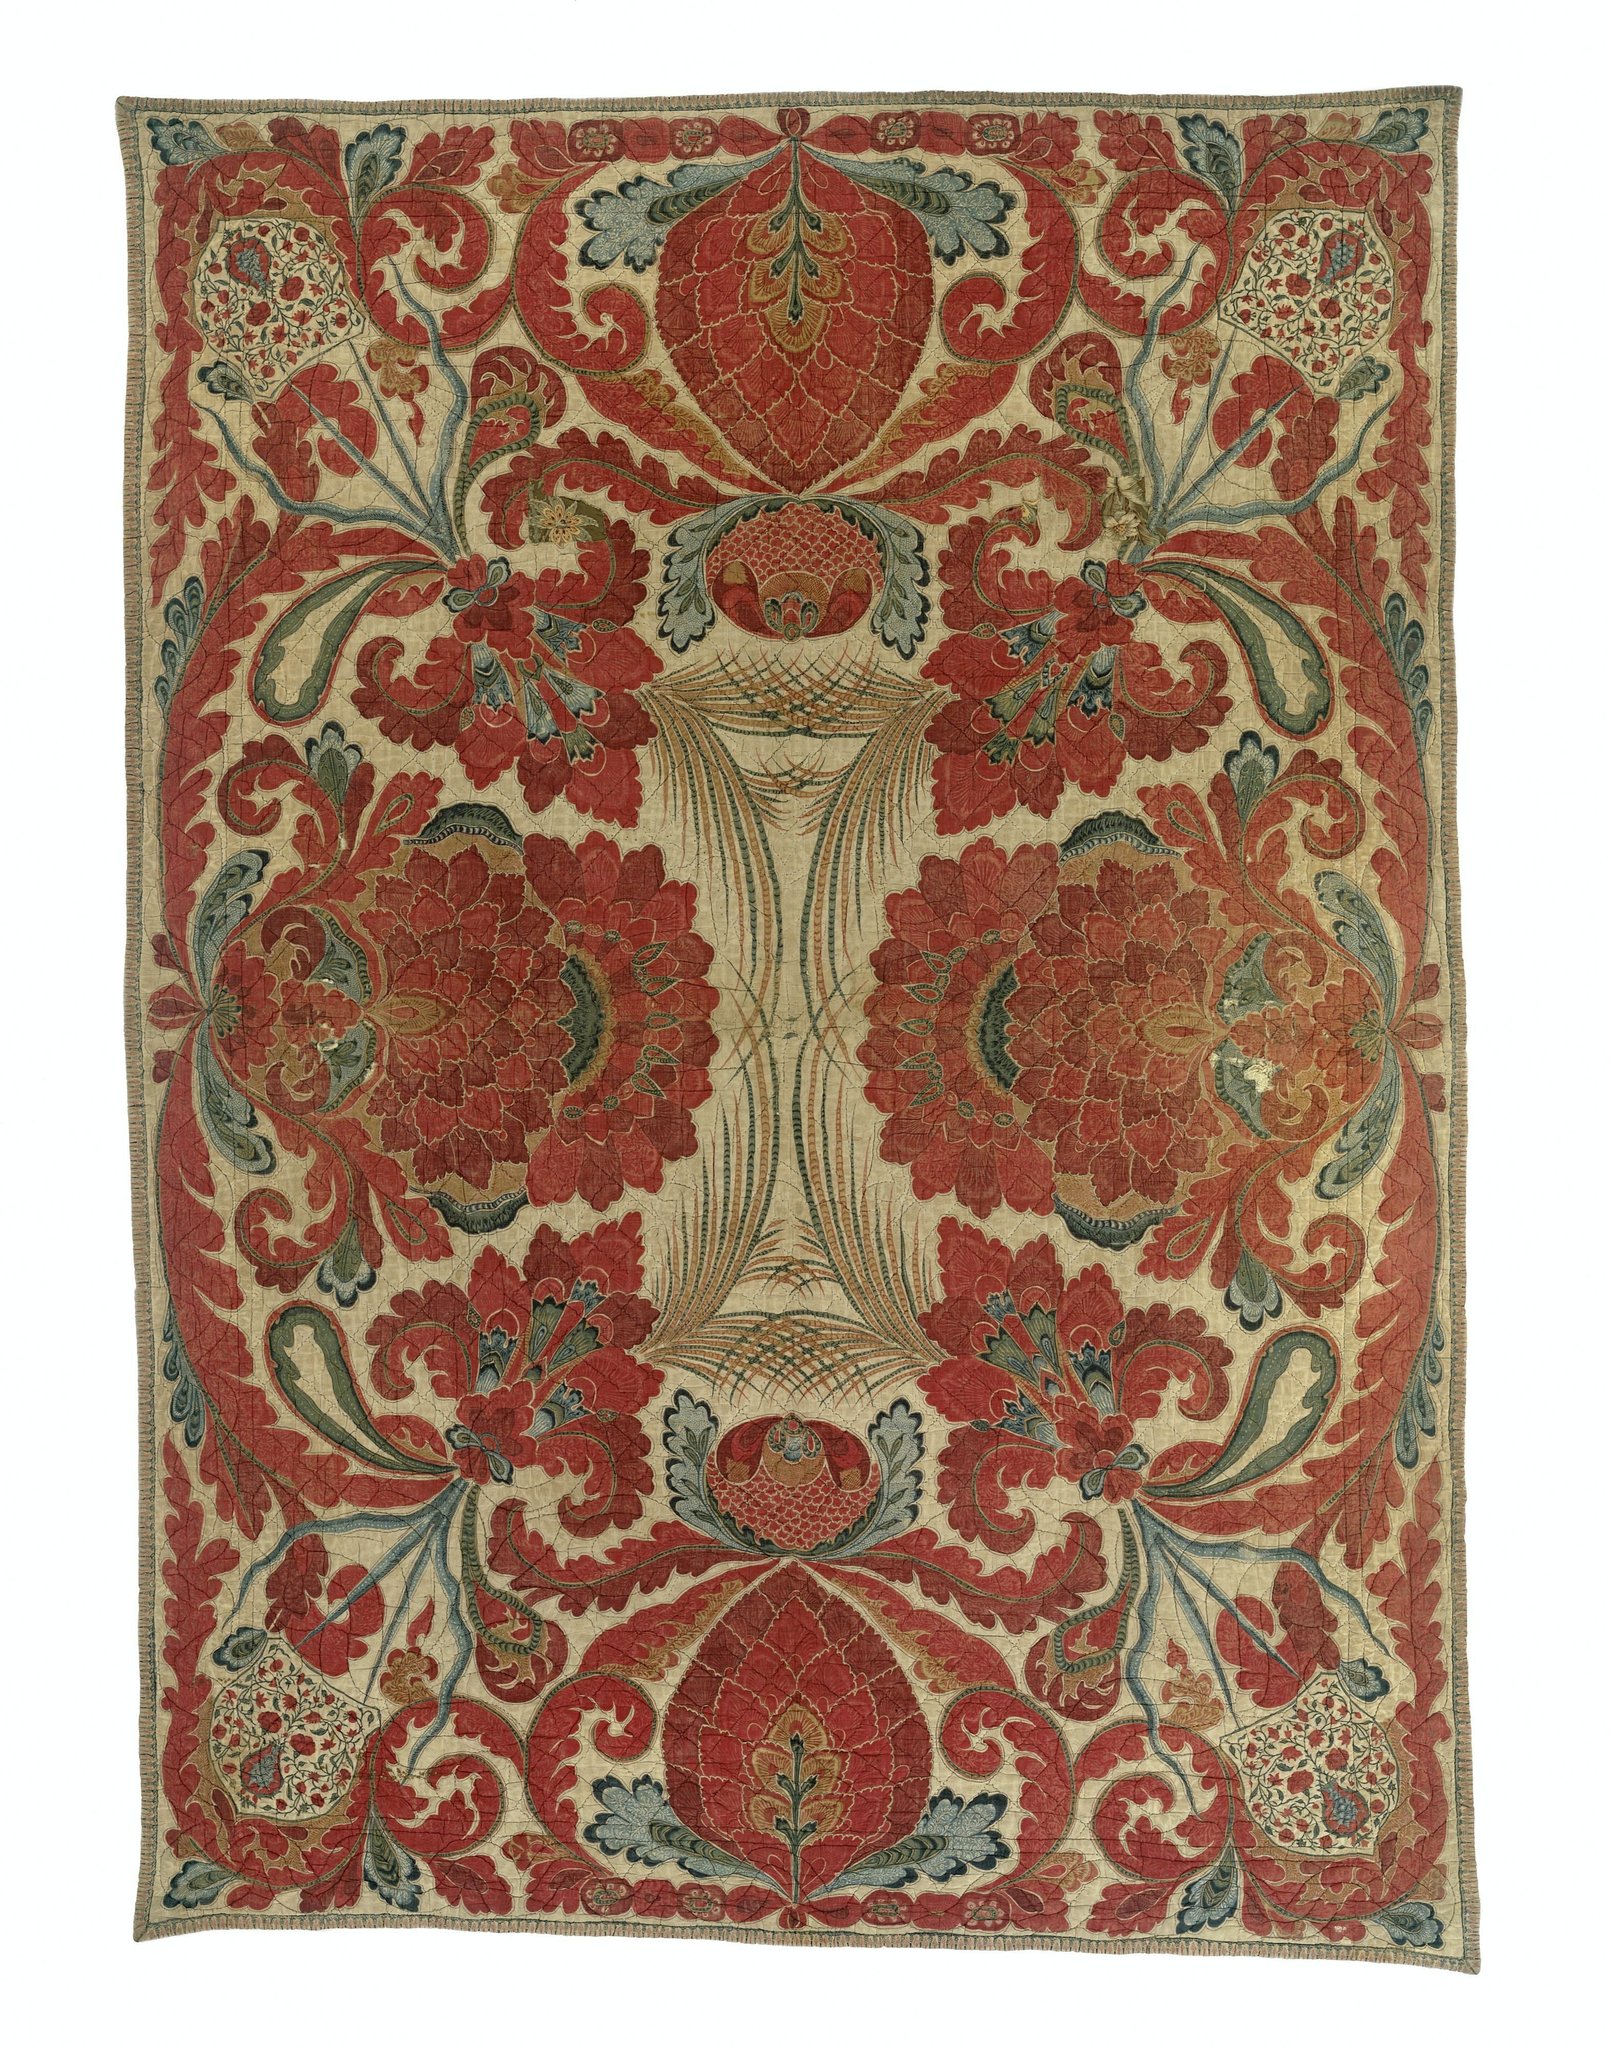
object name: bed covering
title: Deken van sits, gewatteerd en gevoerd met rode katoen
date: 1700-1750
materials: cotton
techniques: printing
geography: india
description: Deken van sits. In het midden van de vier zijden staat, op een wit fond, een groot bloempalmet in rood - twee spitsovaal en twee waaiervormig - op een bladrozet van blauwe en rode voluutrank, waarvan de rode deels de rand vormt, deels de palmet omlijst. In de hoeken een kleinere palmet in de vorm van een fleur de lys en overhoeks geplaatst, waaraan door middel van een gestrikt blauw lint een wapenschild hangt, dat op een wit veld een bloemvaas vertoont met fijne spiraalranken, waaraan rode anjers en granaatappels. De middenpalmetten bestaan uit schubsgewijs en in concentrische bogen gerangschikte bloembladeren en karmijnrood en kraplak met zeer fijne nerftekeningen. De top wordt of gevormd door een pompoen op bladrozet of door een waaiervormige bladrozet. In het midden fijne aigrettes, beurtelings van blauw en rood-geel. Een zeer smalle rand omzoomt het geheel. Gestikt, gewatteerd en gevoerd met rode katoen.